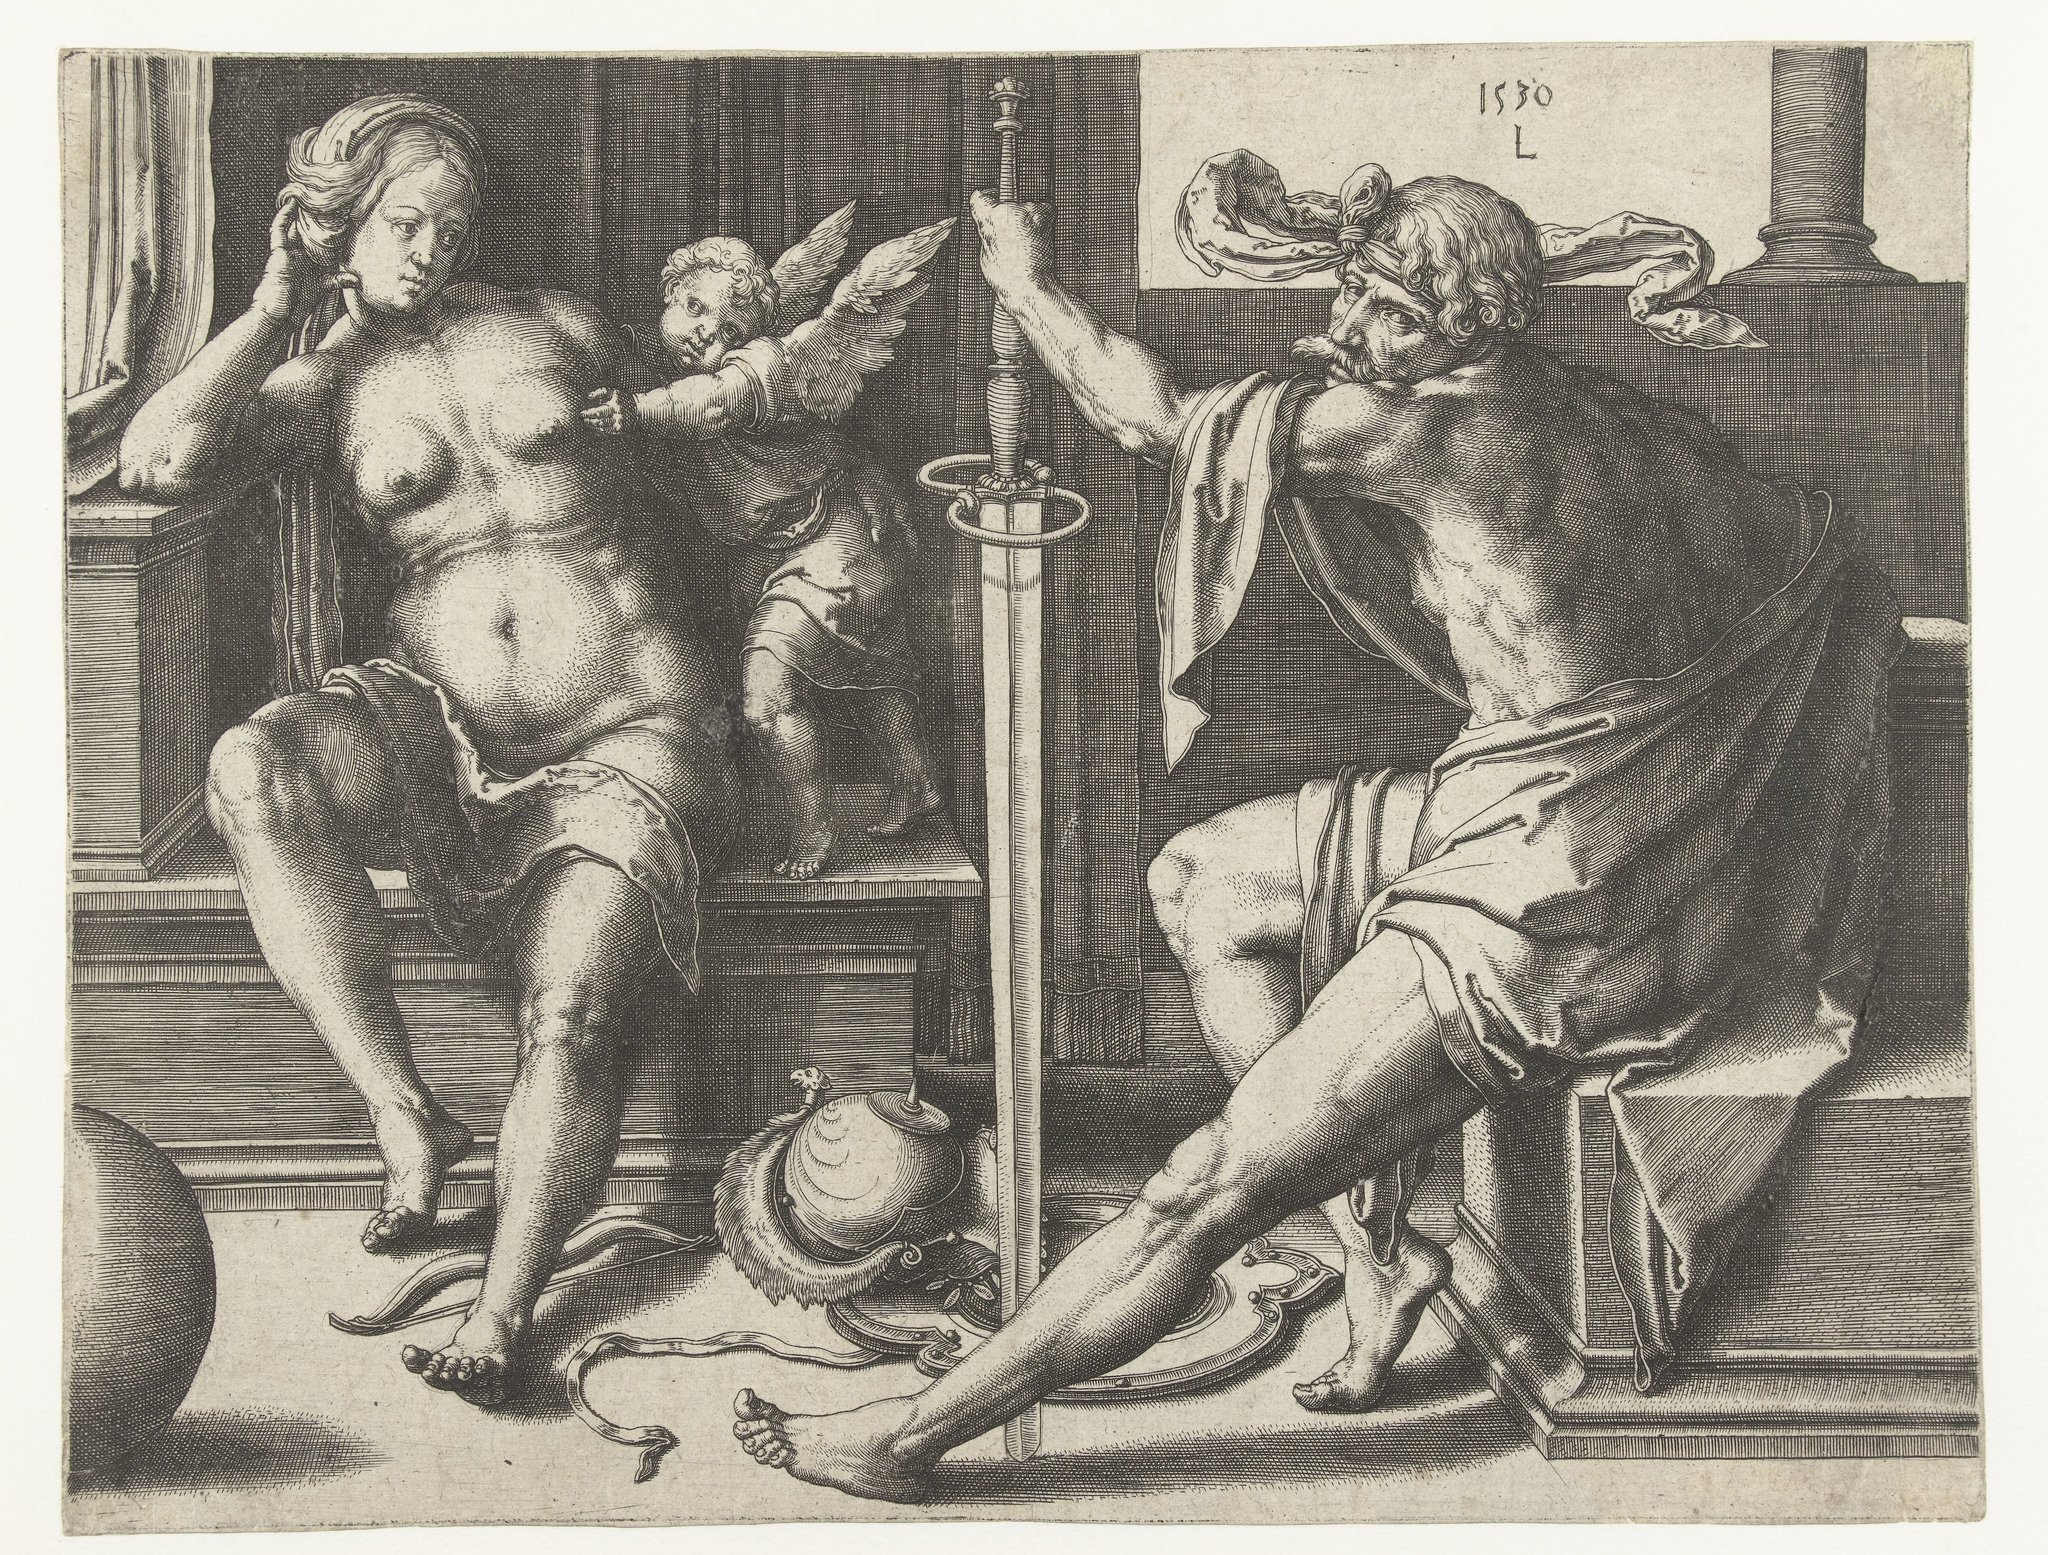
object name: print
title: Mars, Venus en Cupido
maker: lucas van leyden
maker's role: draughtsman, painter, print maker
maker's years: 1494-1533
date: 1530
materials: paper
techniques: engraving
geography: low countries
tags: mars and venus as lovers, (story of) cupid, amor (eros)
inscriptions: signature and date: ‘L 1530’, collector's mark: Lugt 240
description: Venus zittend op bank met Cupido naast haar. Rechts van haar Mars, steunend op een groot zwaard, helm en schild voor hem op de grond.